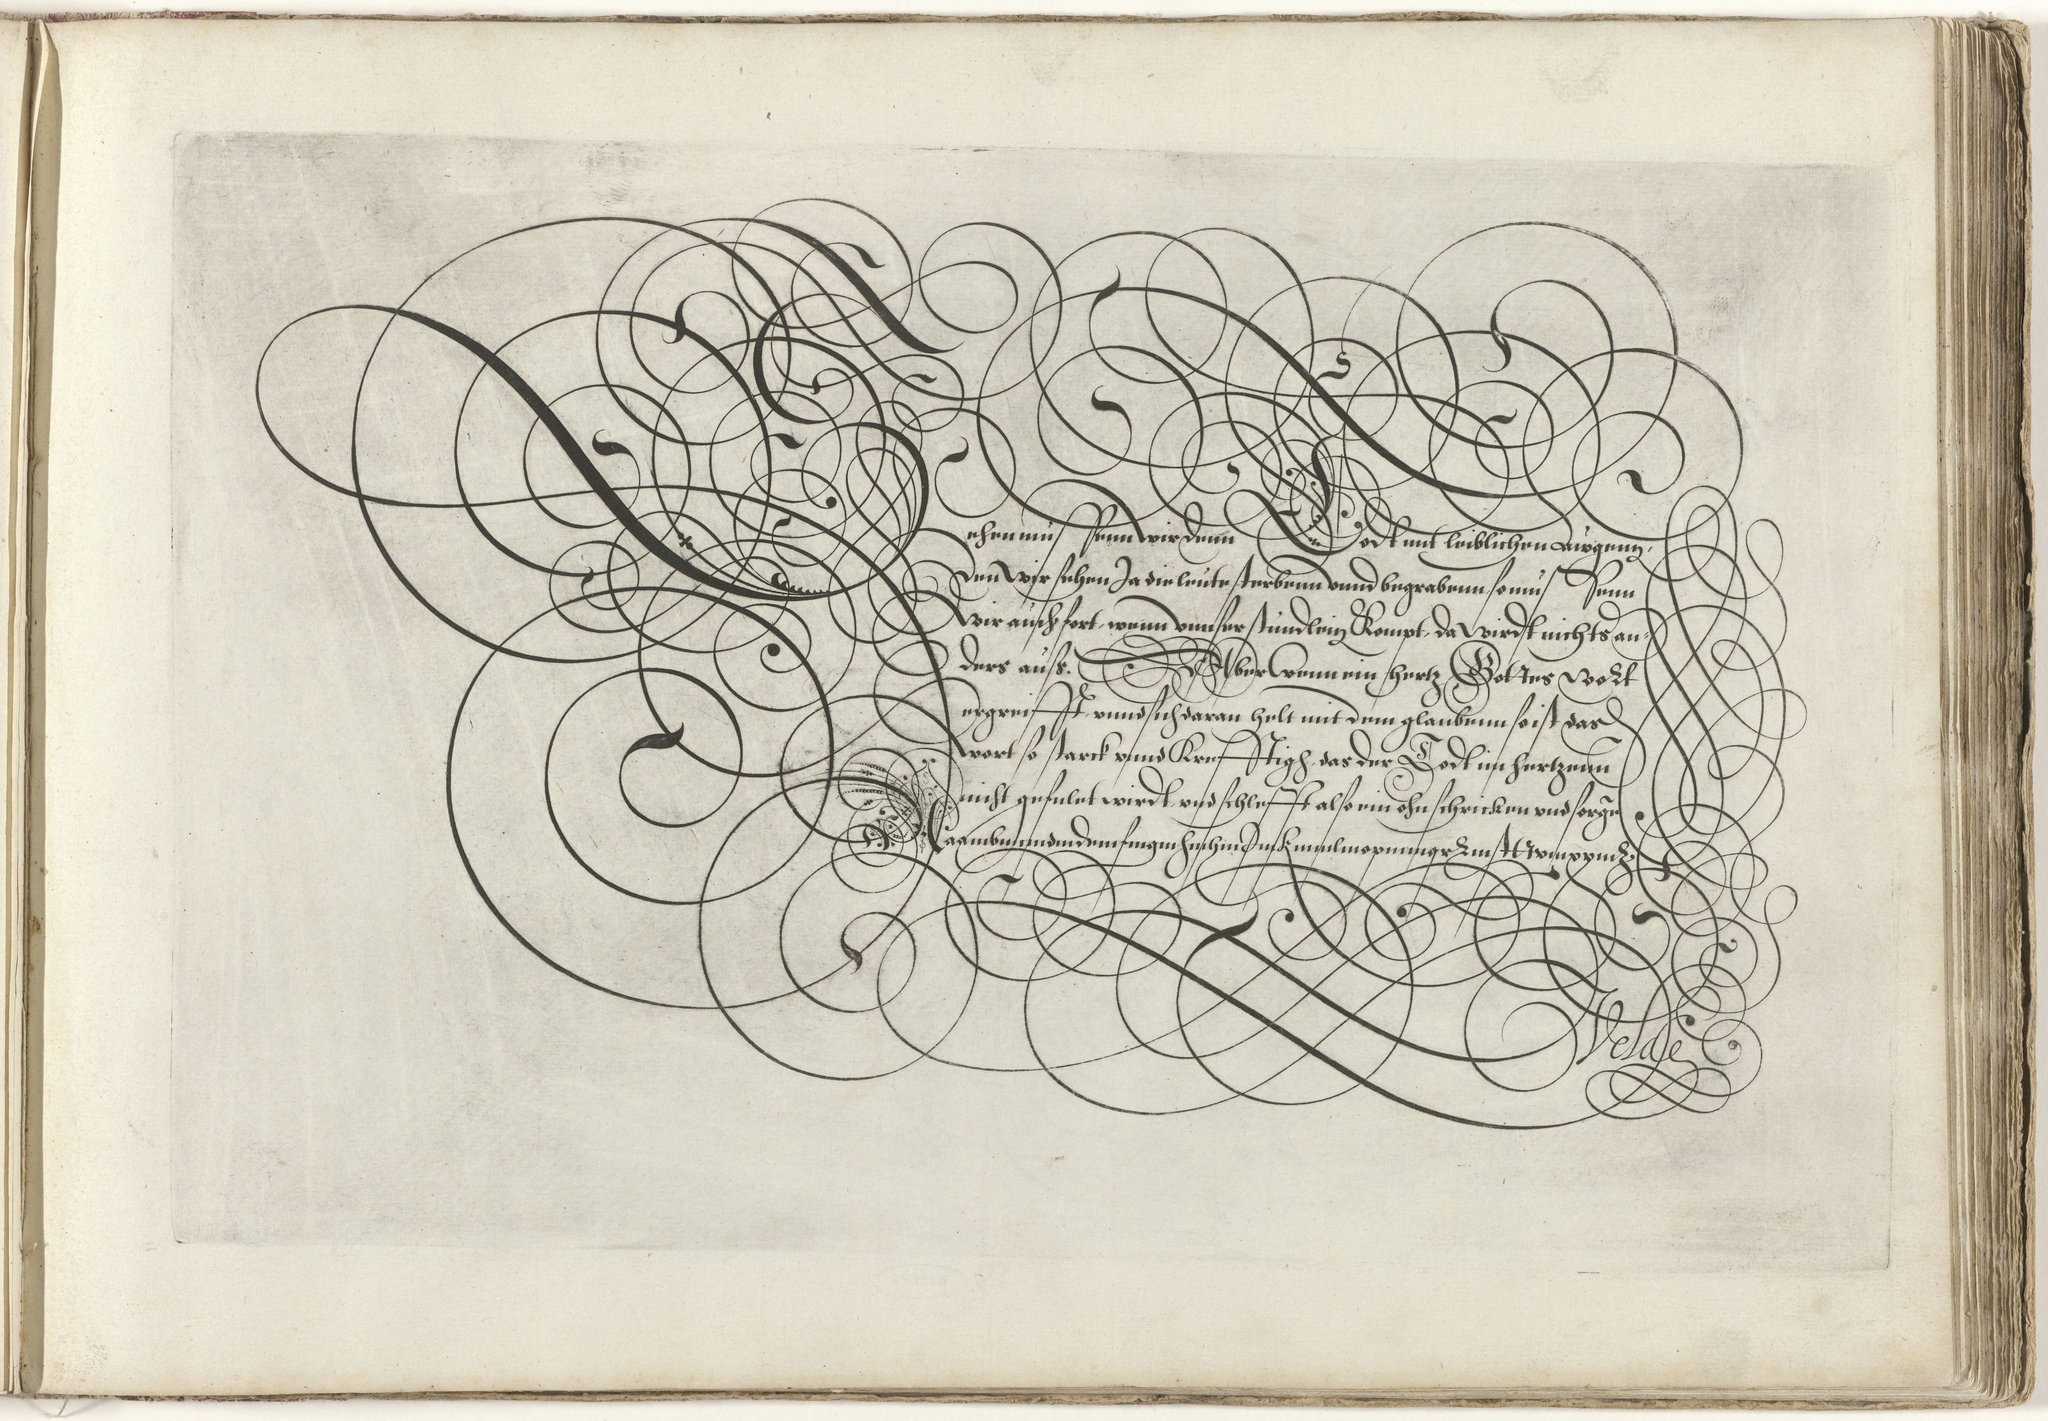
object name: print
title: Spieghel der schrijfkonste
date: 1605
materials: paper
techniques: engraving, intaglio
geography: amsterdam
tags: calligraphy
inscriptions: collector's mark: Lugt 2228, collector's mark: Lugt 2760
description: Schrijfvoorbeeld met initiaal S en acht regels tekst in het Duits: Sehen ... Het voorbeeld eindigt met een onderkastalfabet in de betreffende hand. De tekst is omlijst door krulwerk. De prent maakt deel uit van een album.